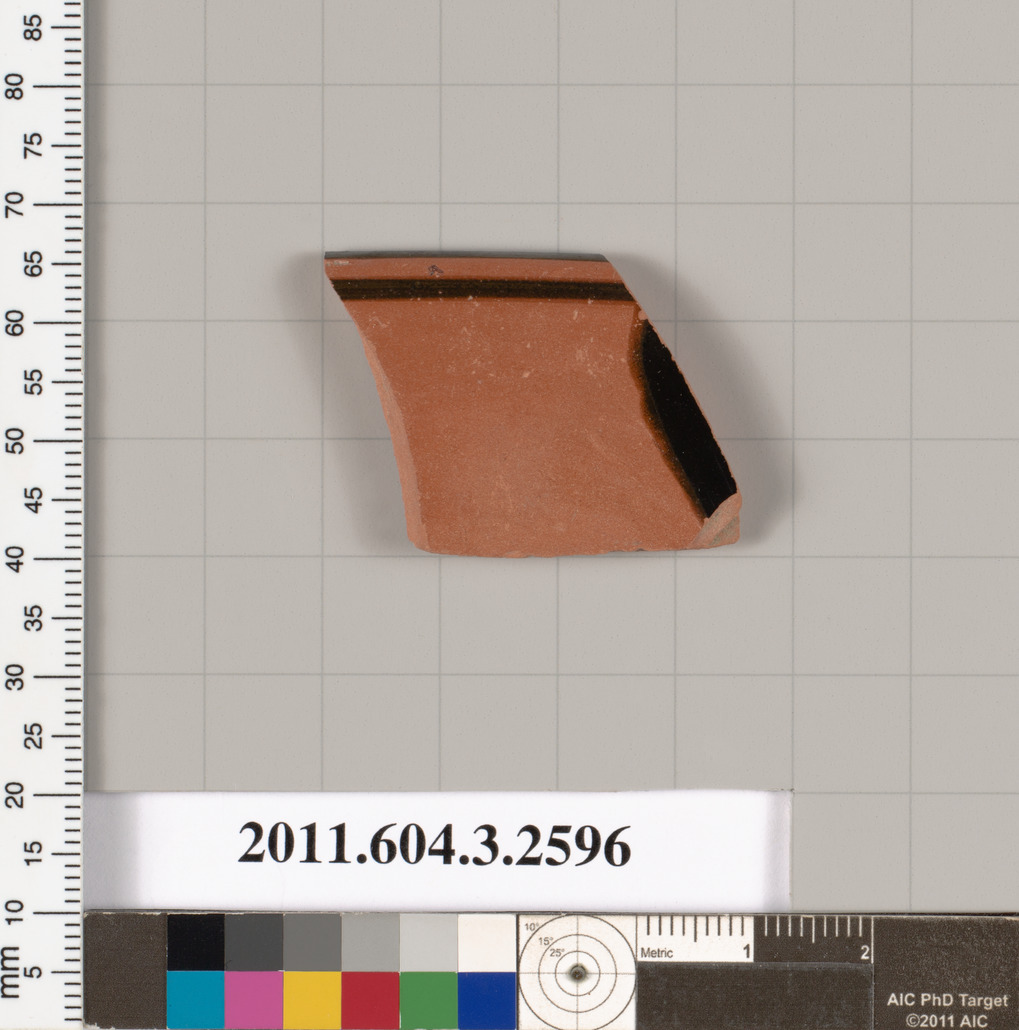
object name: kylix fragment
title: Terracotta rim fragment of a kylix (drinking cup)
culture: greek, attic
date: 575-525 BCE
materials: terracotta